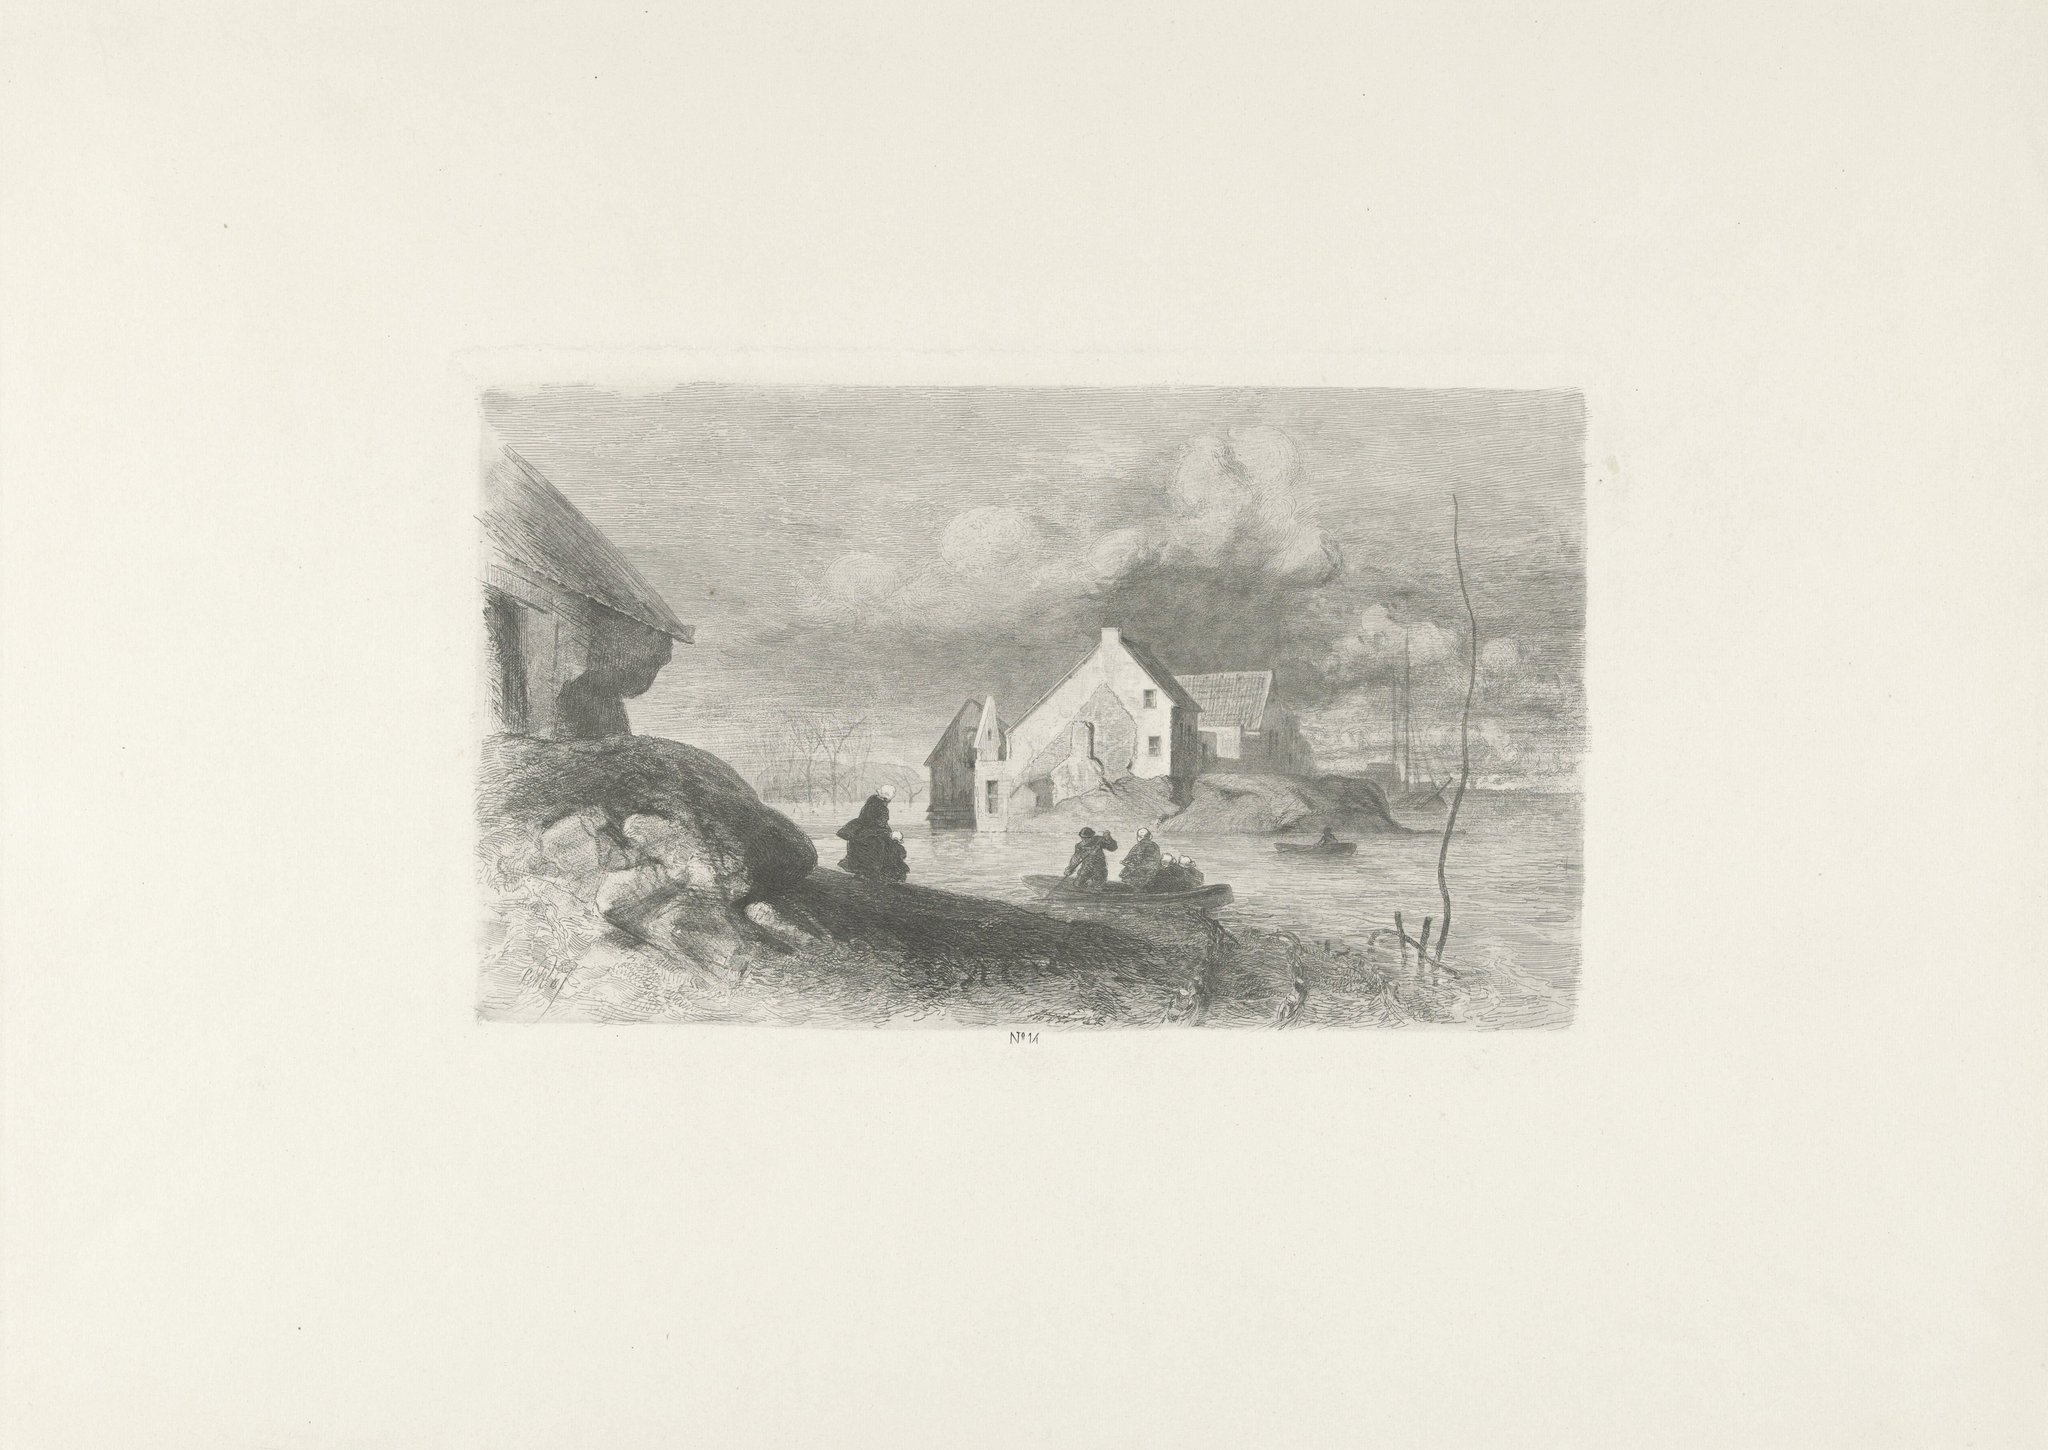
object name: print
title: Watersnoodramp 1855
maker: charles rochussen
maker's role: draughtsman, painter, print maker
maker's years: 1814-1894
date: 1855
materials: paper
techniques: etching, roulette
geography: amsterdam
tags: rescue work during a flood, flood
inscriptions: collector's mark: Lugt 2228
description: Overstroming in het dorp Lith. Met een roeiboot wordt een aantal personen geëvacueerd. De prent is deel van een serie van 24 prenten over de Watersnoodramp van 1855.